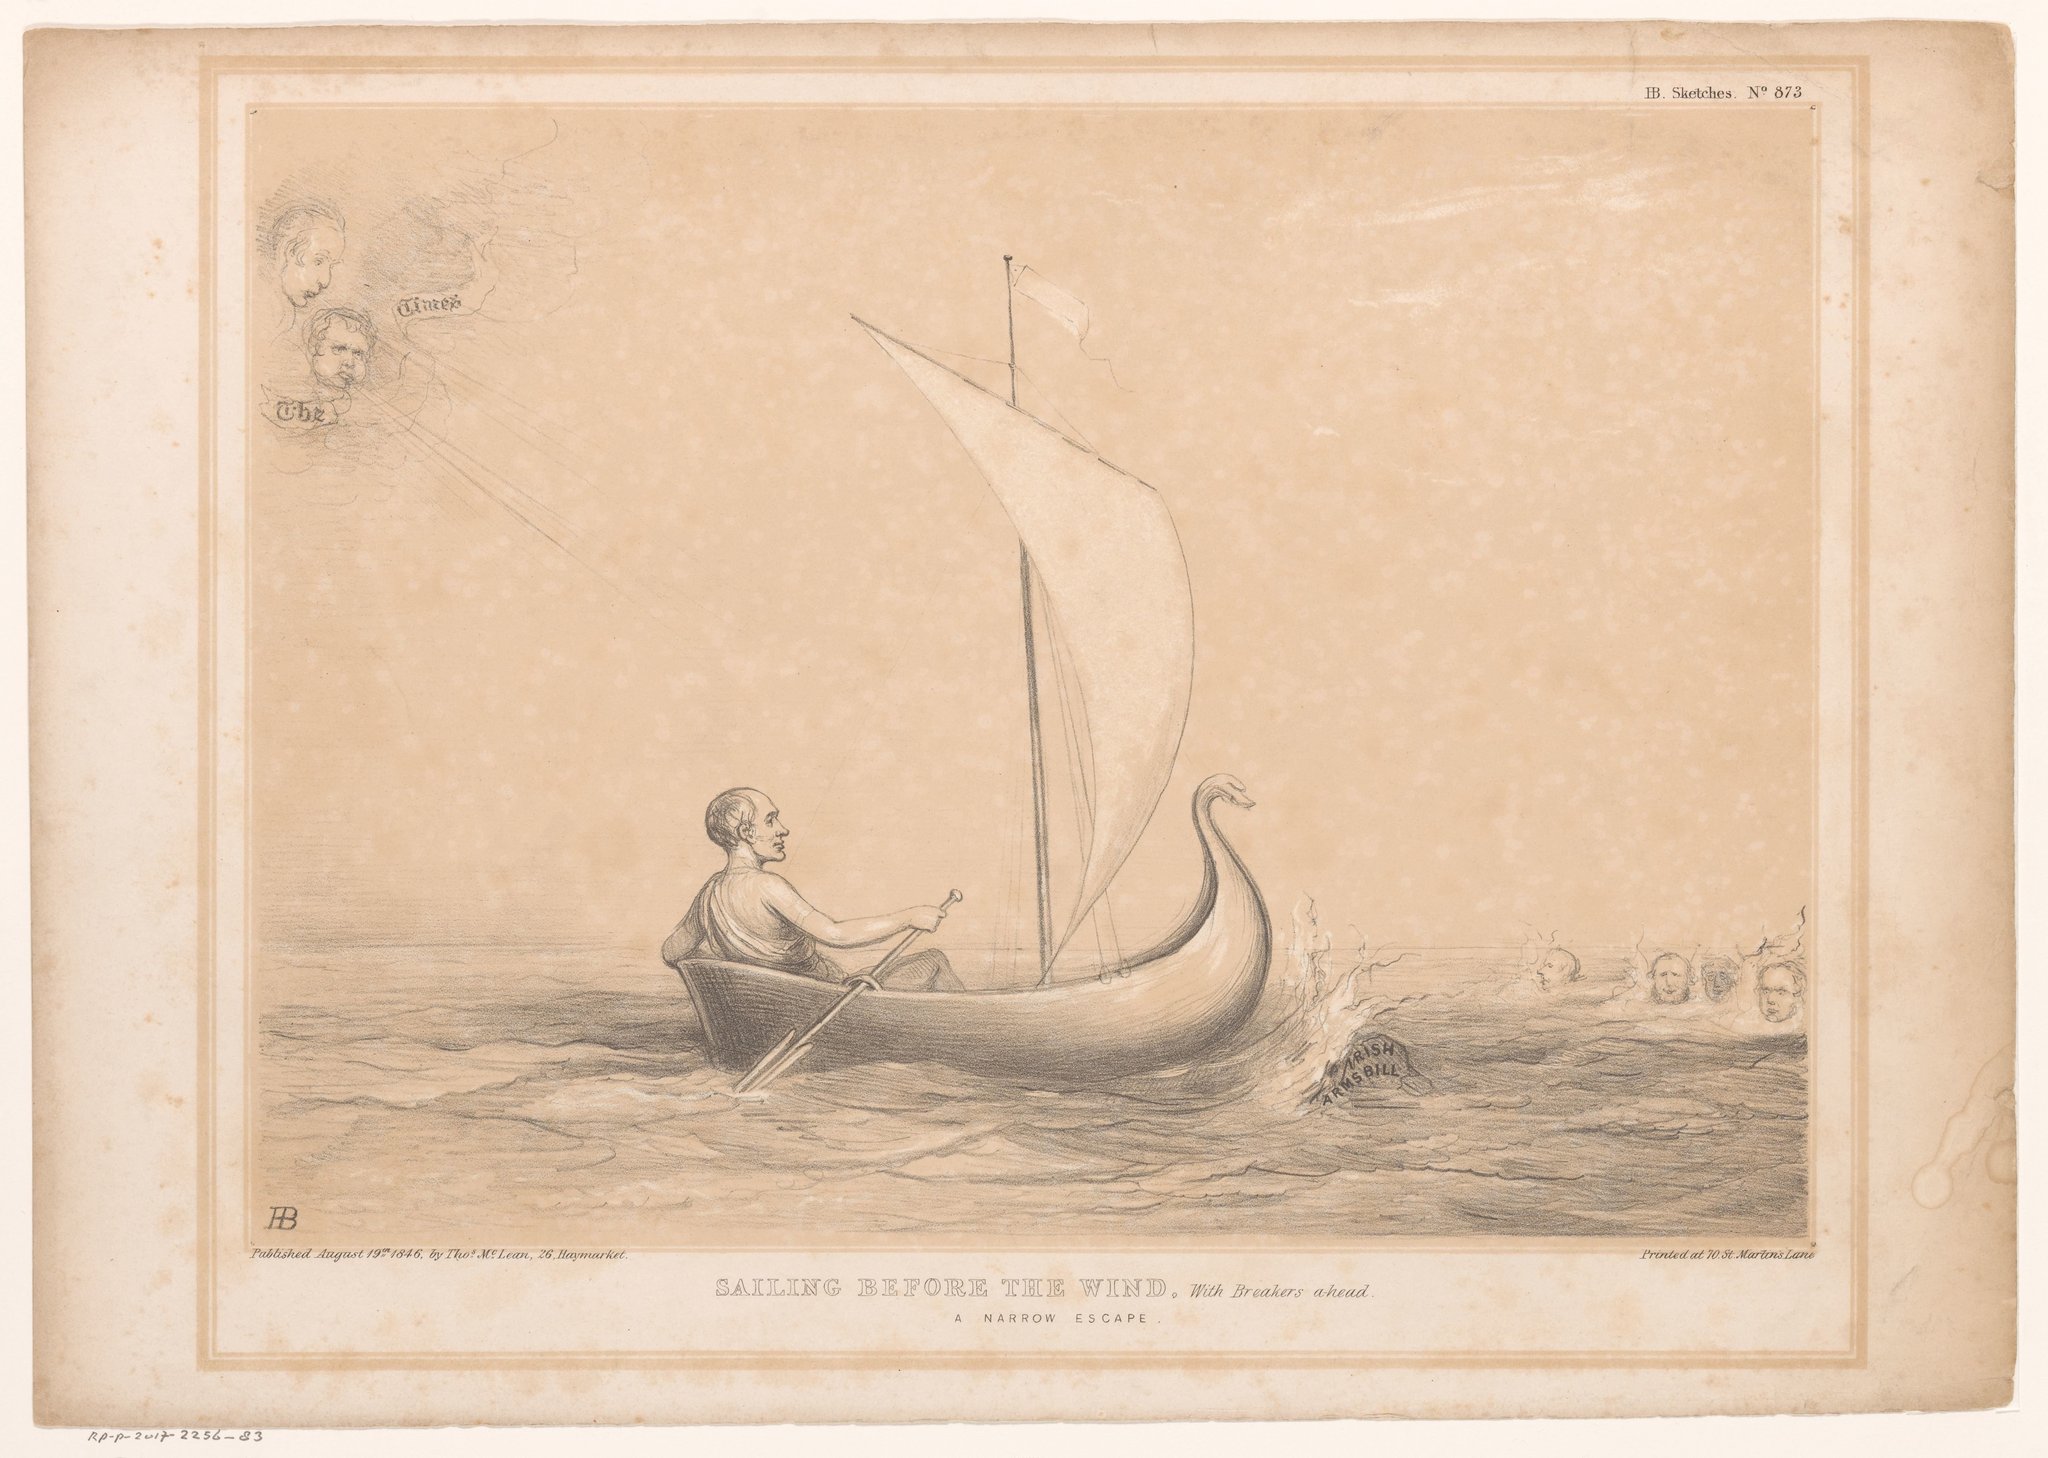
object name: cartoon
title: Sailing before the wind, With Breakers ahead. A narrow escape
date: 1846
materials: paper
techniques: tone lithography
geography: london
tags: politician, sailing-ship, sailing-boat, political caricatures and satires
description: Spotprent uit 1846 met Lord Russell in een zeilbootje op zee. Uitgegeven als nr. 873 in de serie HB Sketches.